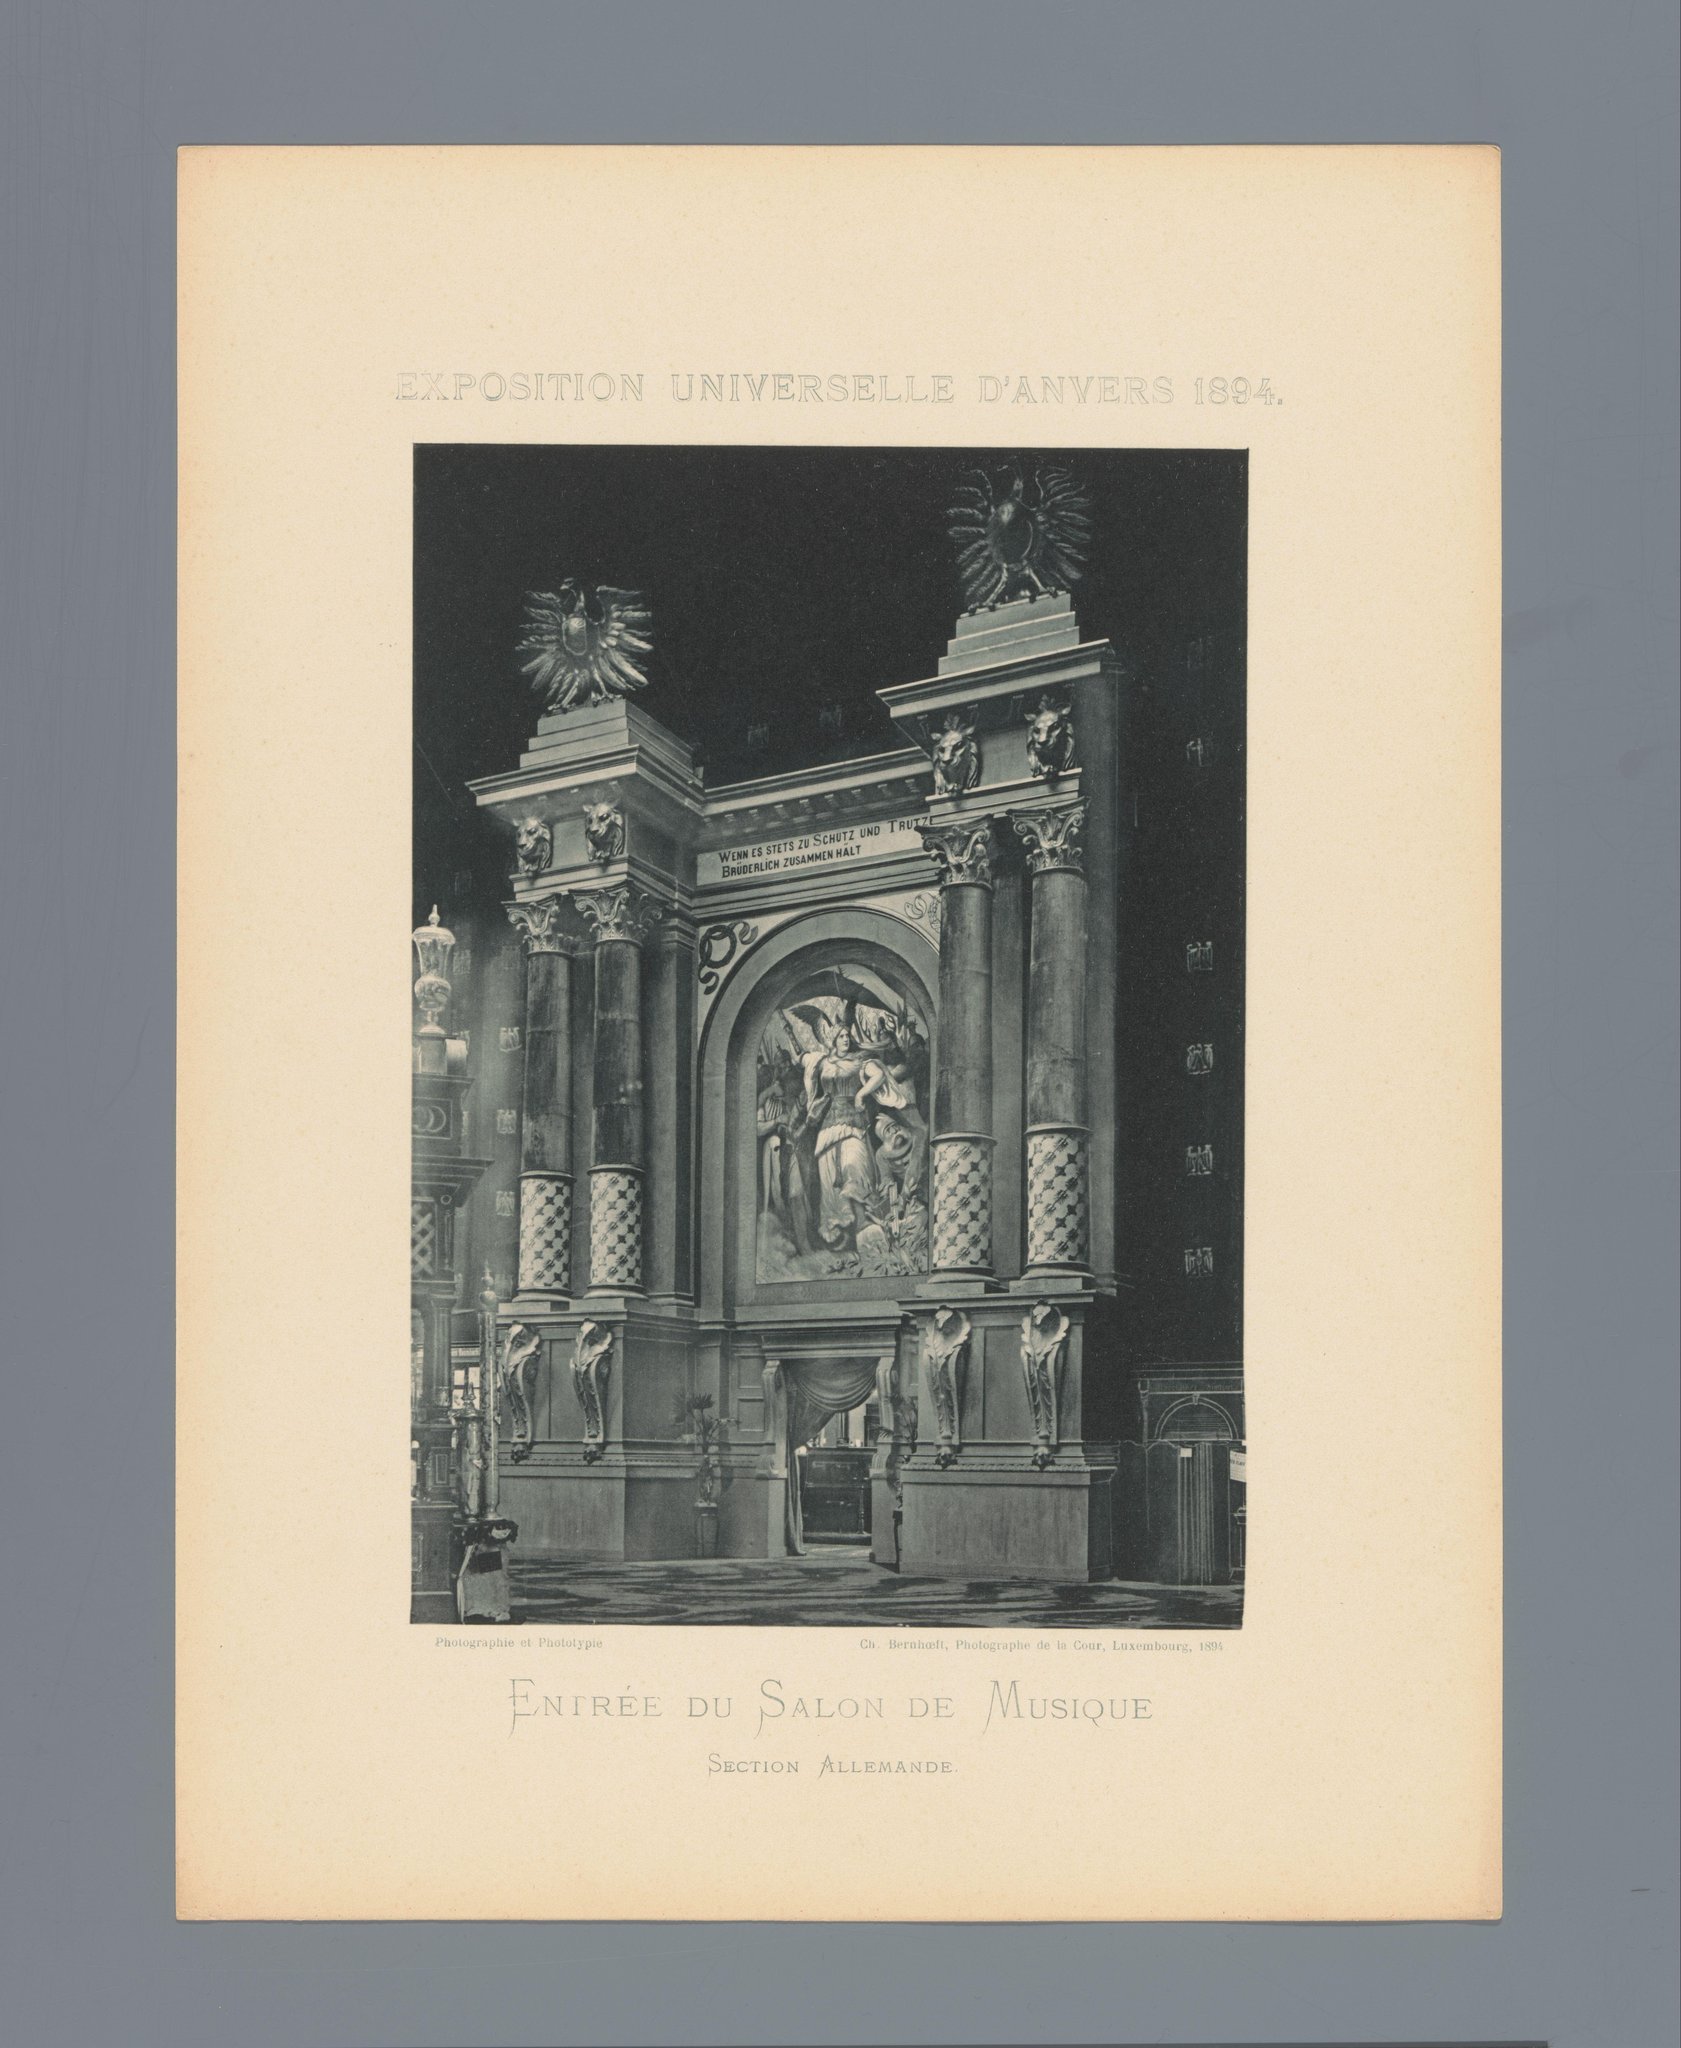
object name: photomechanical print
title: Ingang van de Salon de Musique van de Duitse afdeling tijdens de Wereldtentoonstelling van 1894 te Antwerpen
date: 1894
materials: paper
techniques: photograph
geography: antwerp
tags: world fair, world exhibition, gate, entrance, antwerp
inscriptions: inscription: ‘Exposition Universelle D'Anvers 1894’